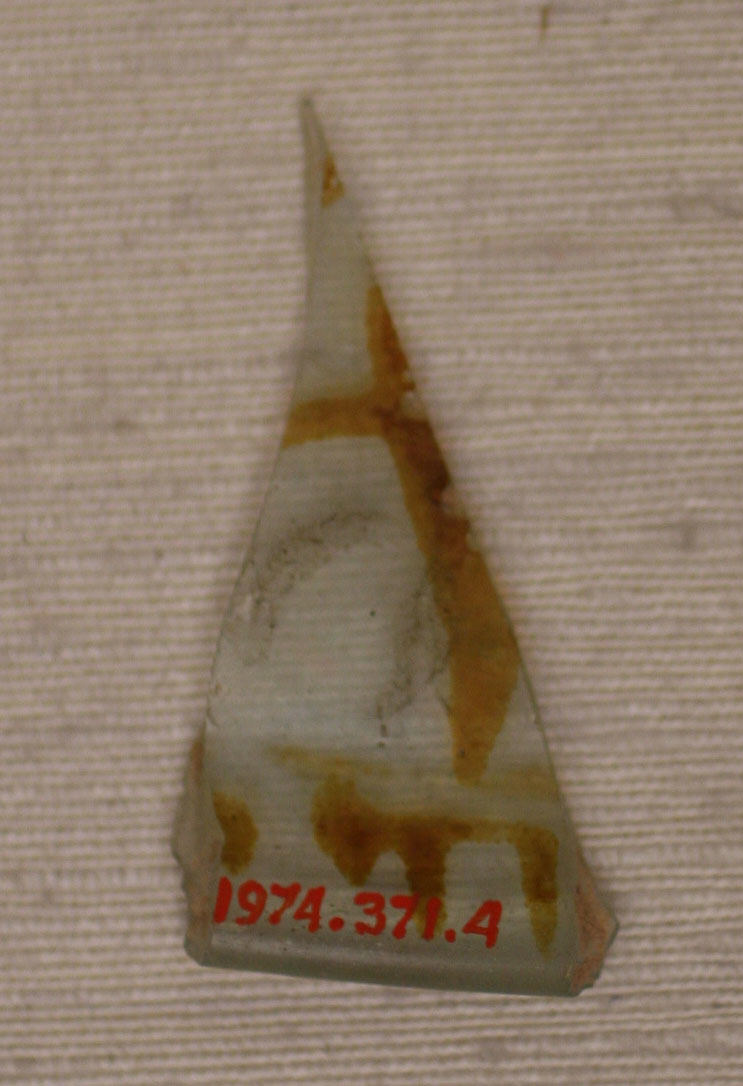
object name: fragment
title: Glass Fragment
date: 801-900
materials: glass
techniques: luster painting, stain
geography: egypt or iraq